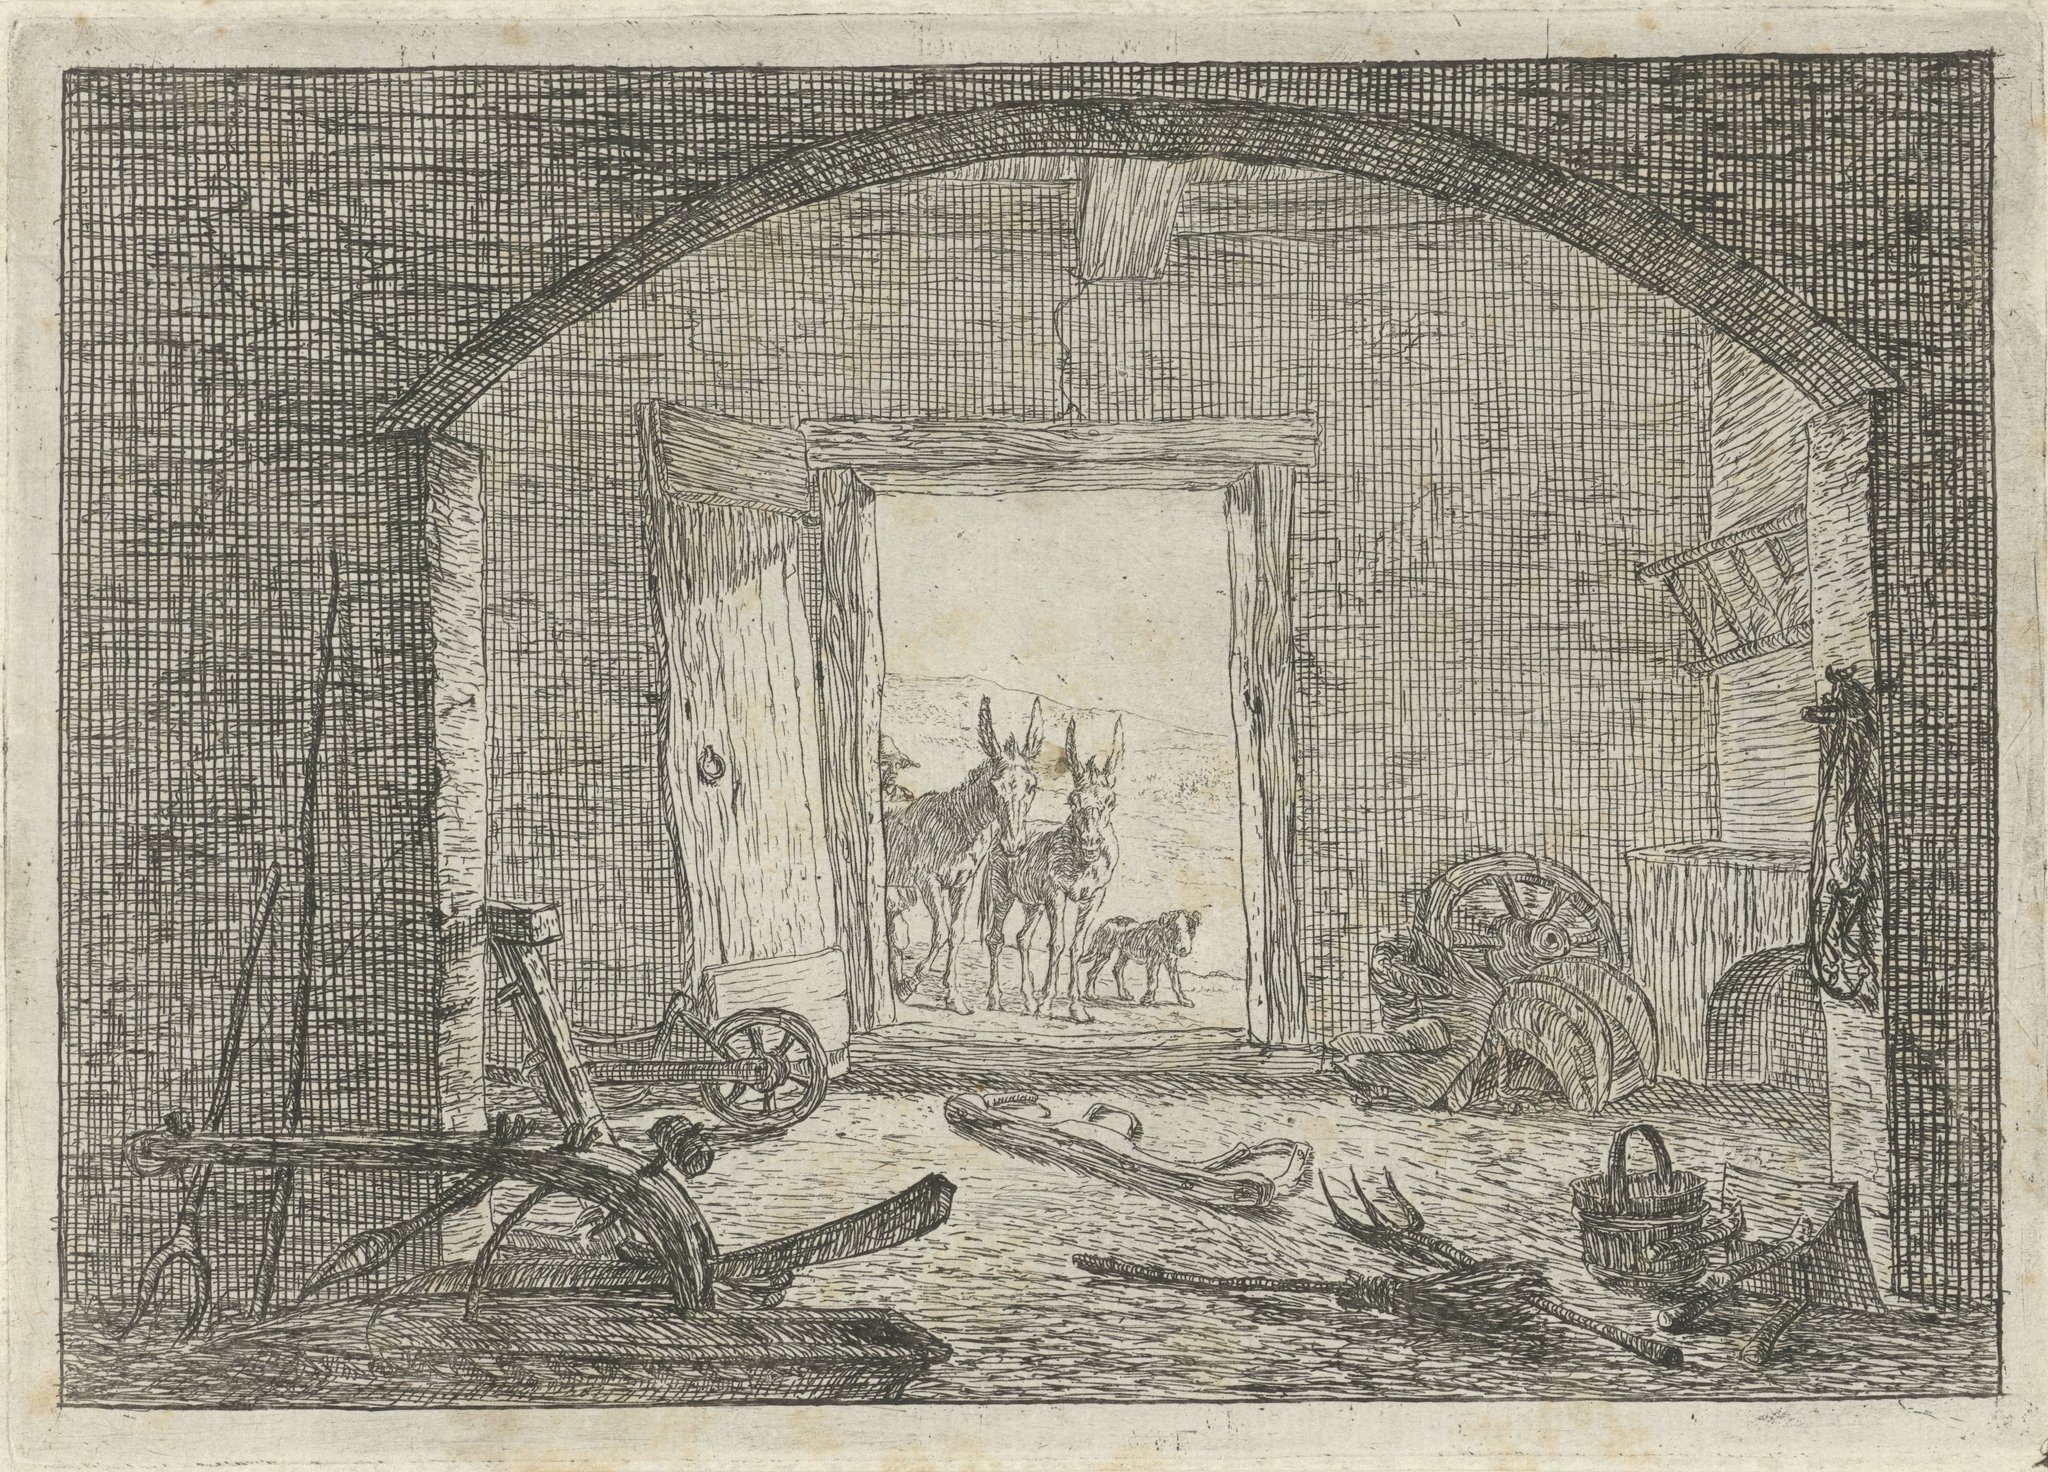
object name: print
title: Verschillende dieren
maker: pieter bodding van laer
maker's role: draughtsman, painter, print maker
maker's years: 1599-1642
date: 1636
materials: paper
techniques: etching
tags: barn, ass, donkey, agricultural implements, dog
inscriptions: collector's mark: Lugt 10, collector's mark: Lugt 11, number: ‘2’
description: Interieur van een schuur met verschillende landbouwwerktuigen. Voor de open deur staan twee ezels en een hond. De prent maakt deel uit van een achtdelige serie met voorstellingen van verschillende dieren.